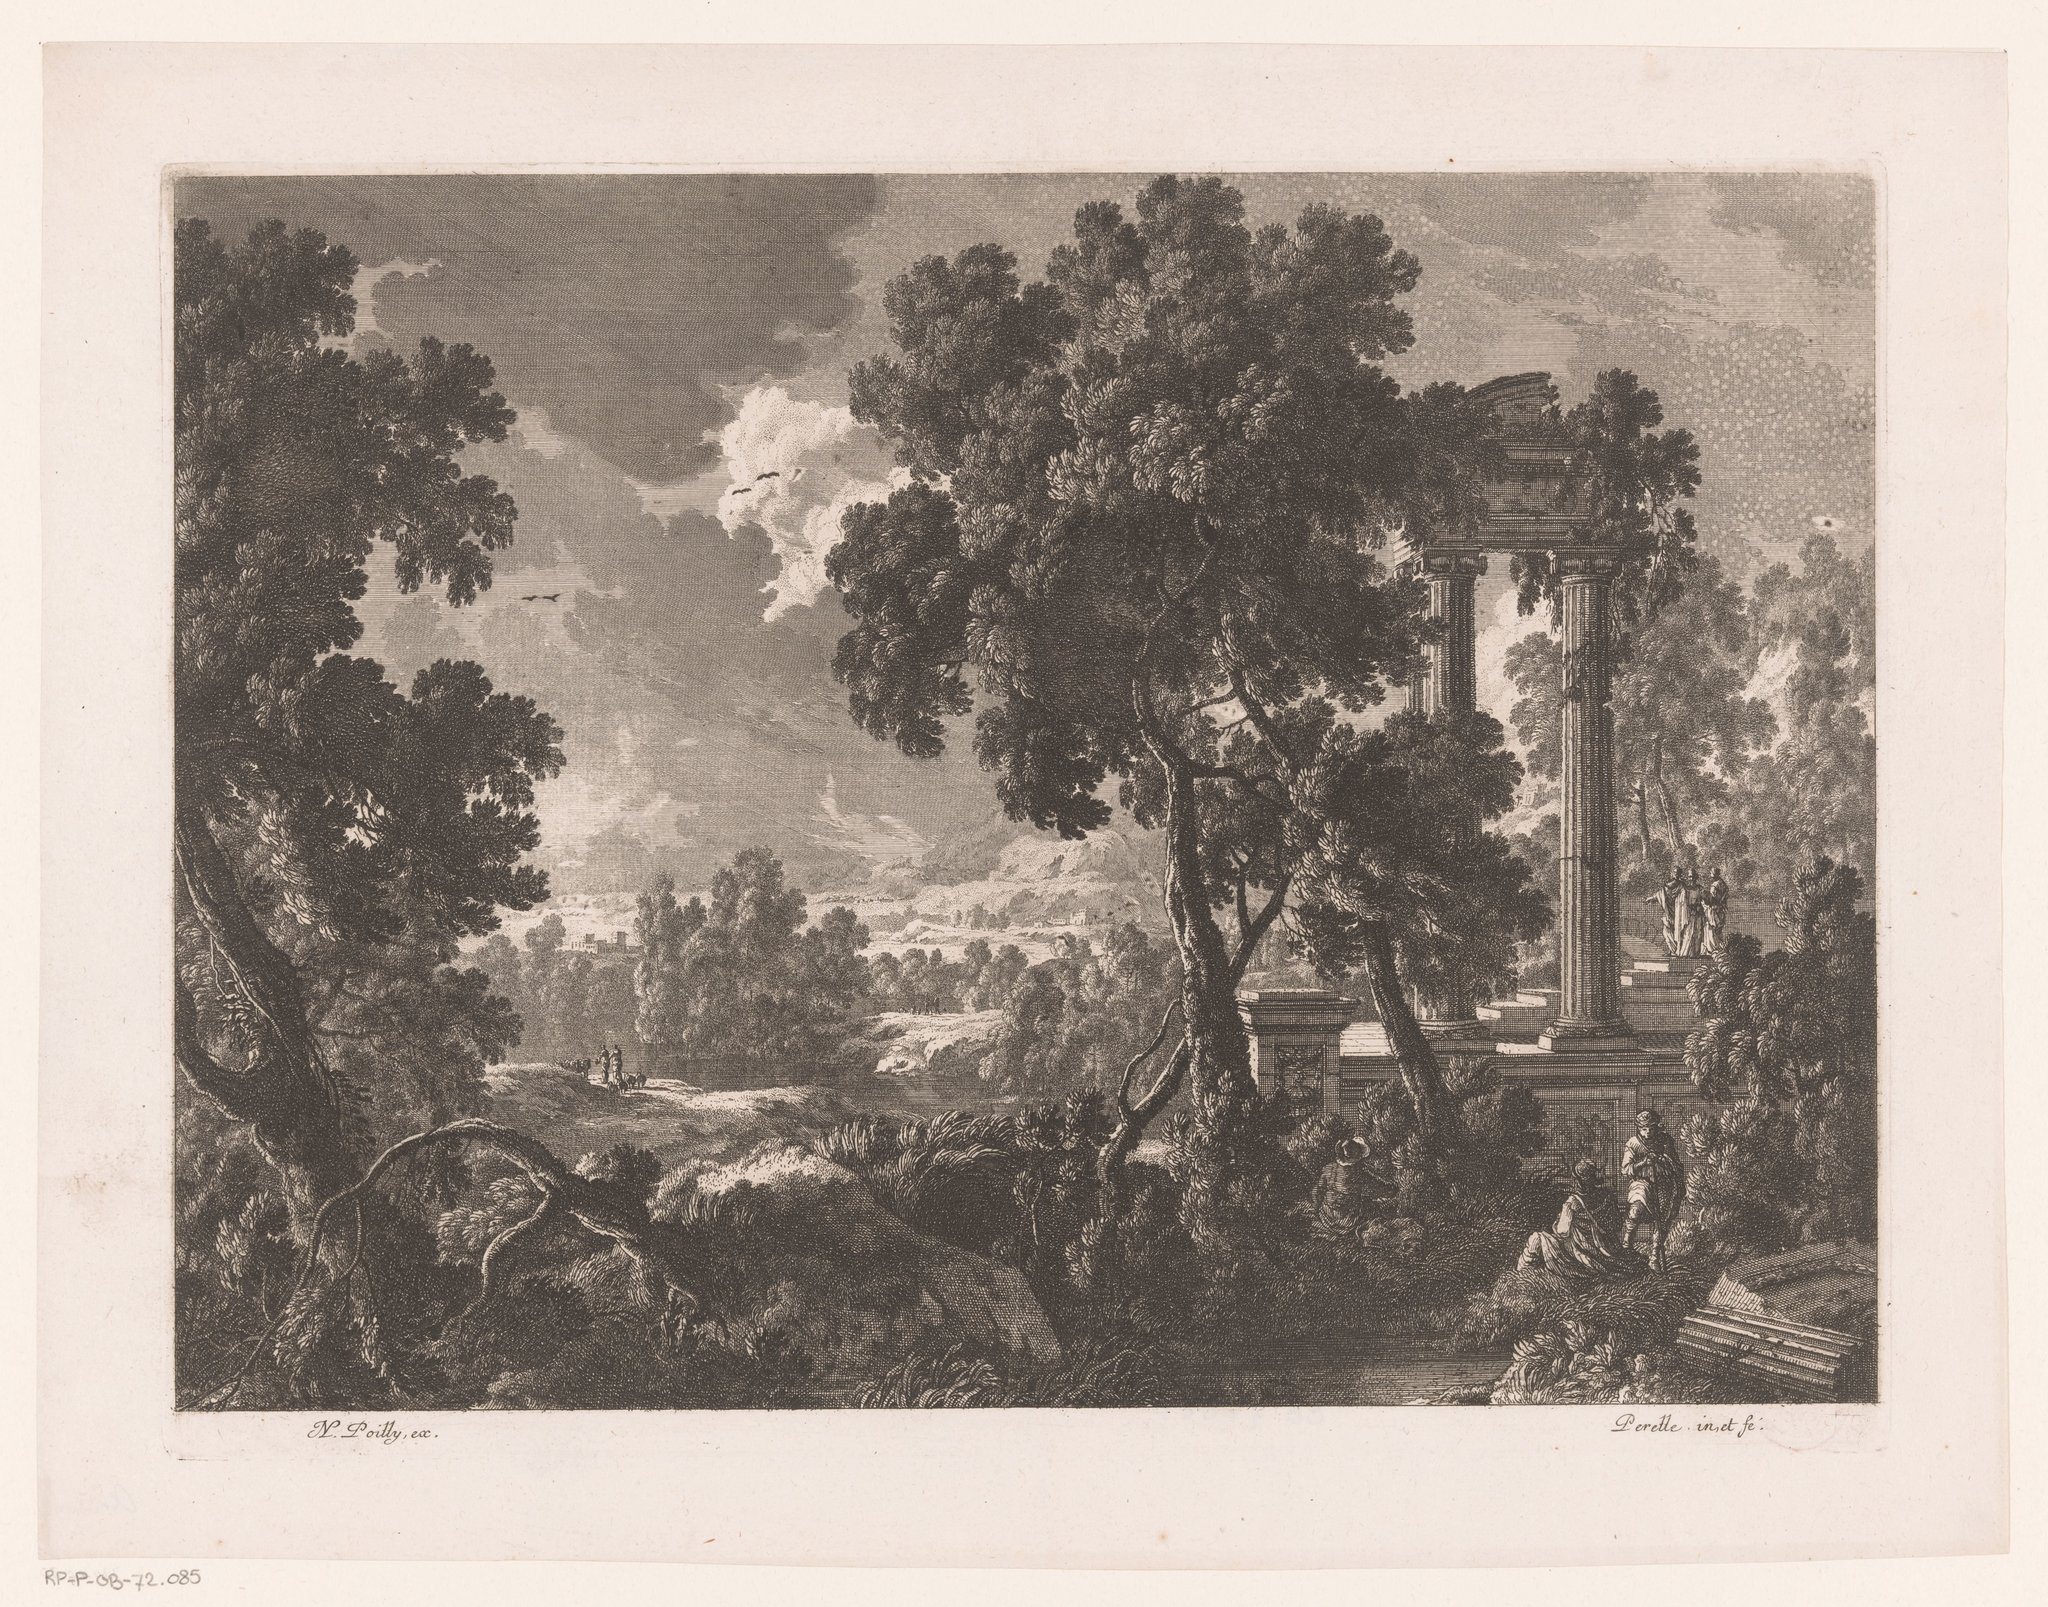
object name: print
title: Landschap met figuren bij antieke ruïne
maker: nicolas de poilly (i)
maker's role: print maker, publisher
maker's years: 1626-1696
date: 1636-1695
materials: paper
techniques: engraving, etching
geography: paris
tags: landscape with ruins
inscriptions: collector's mark: Lugt 240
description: Prenten met het signatuur 'Perelle' kunnen zowel door vader Gabriel als door zonen Nicolas en Adam gemaakt zijn.